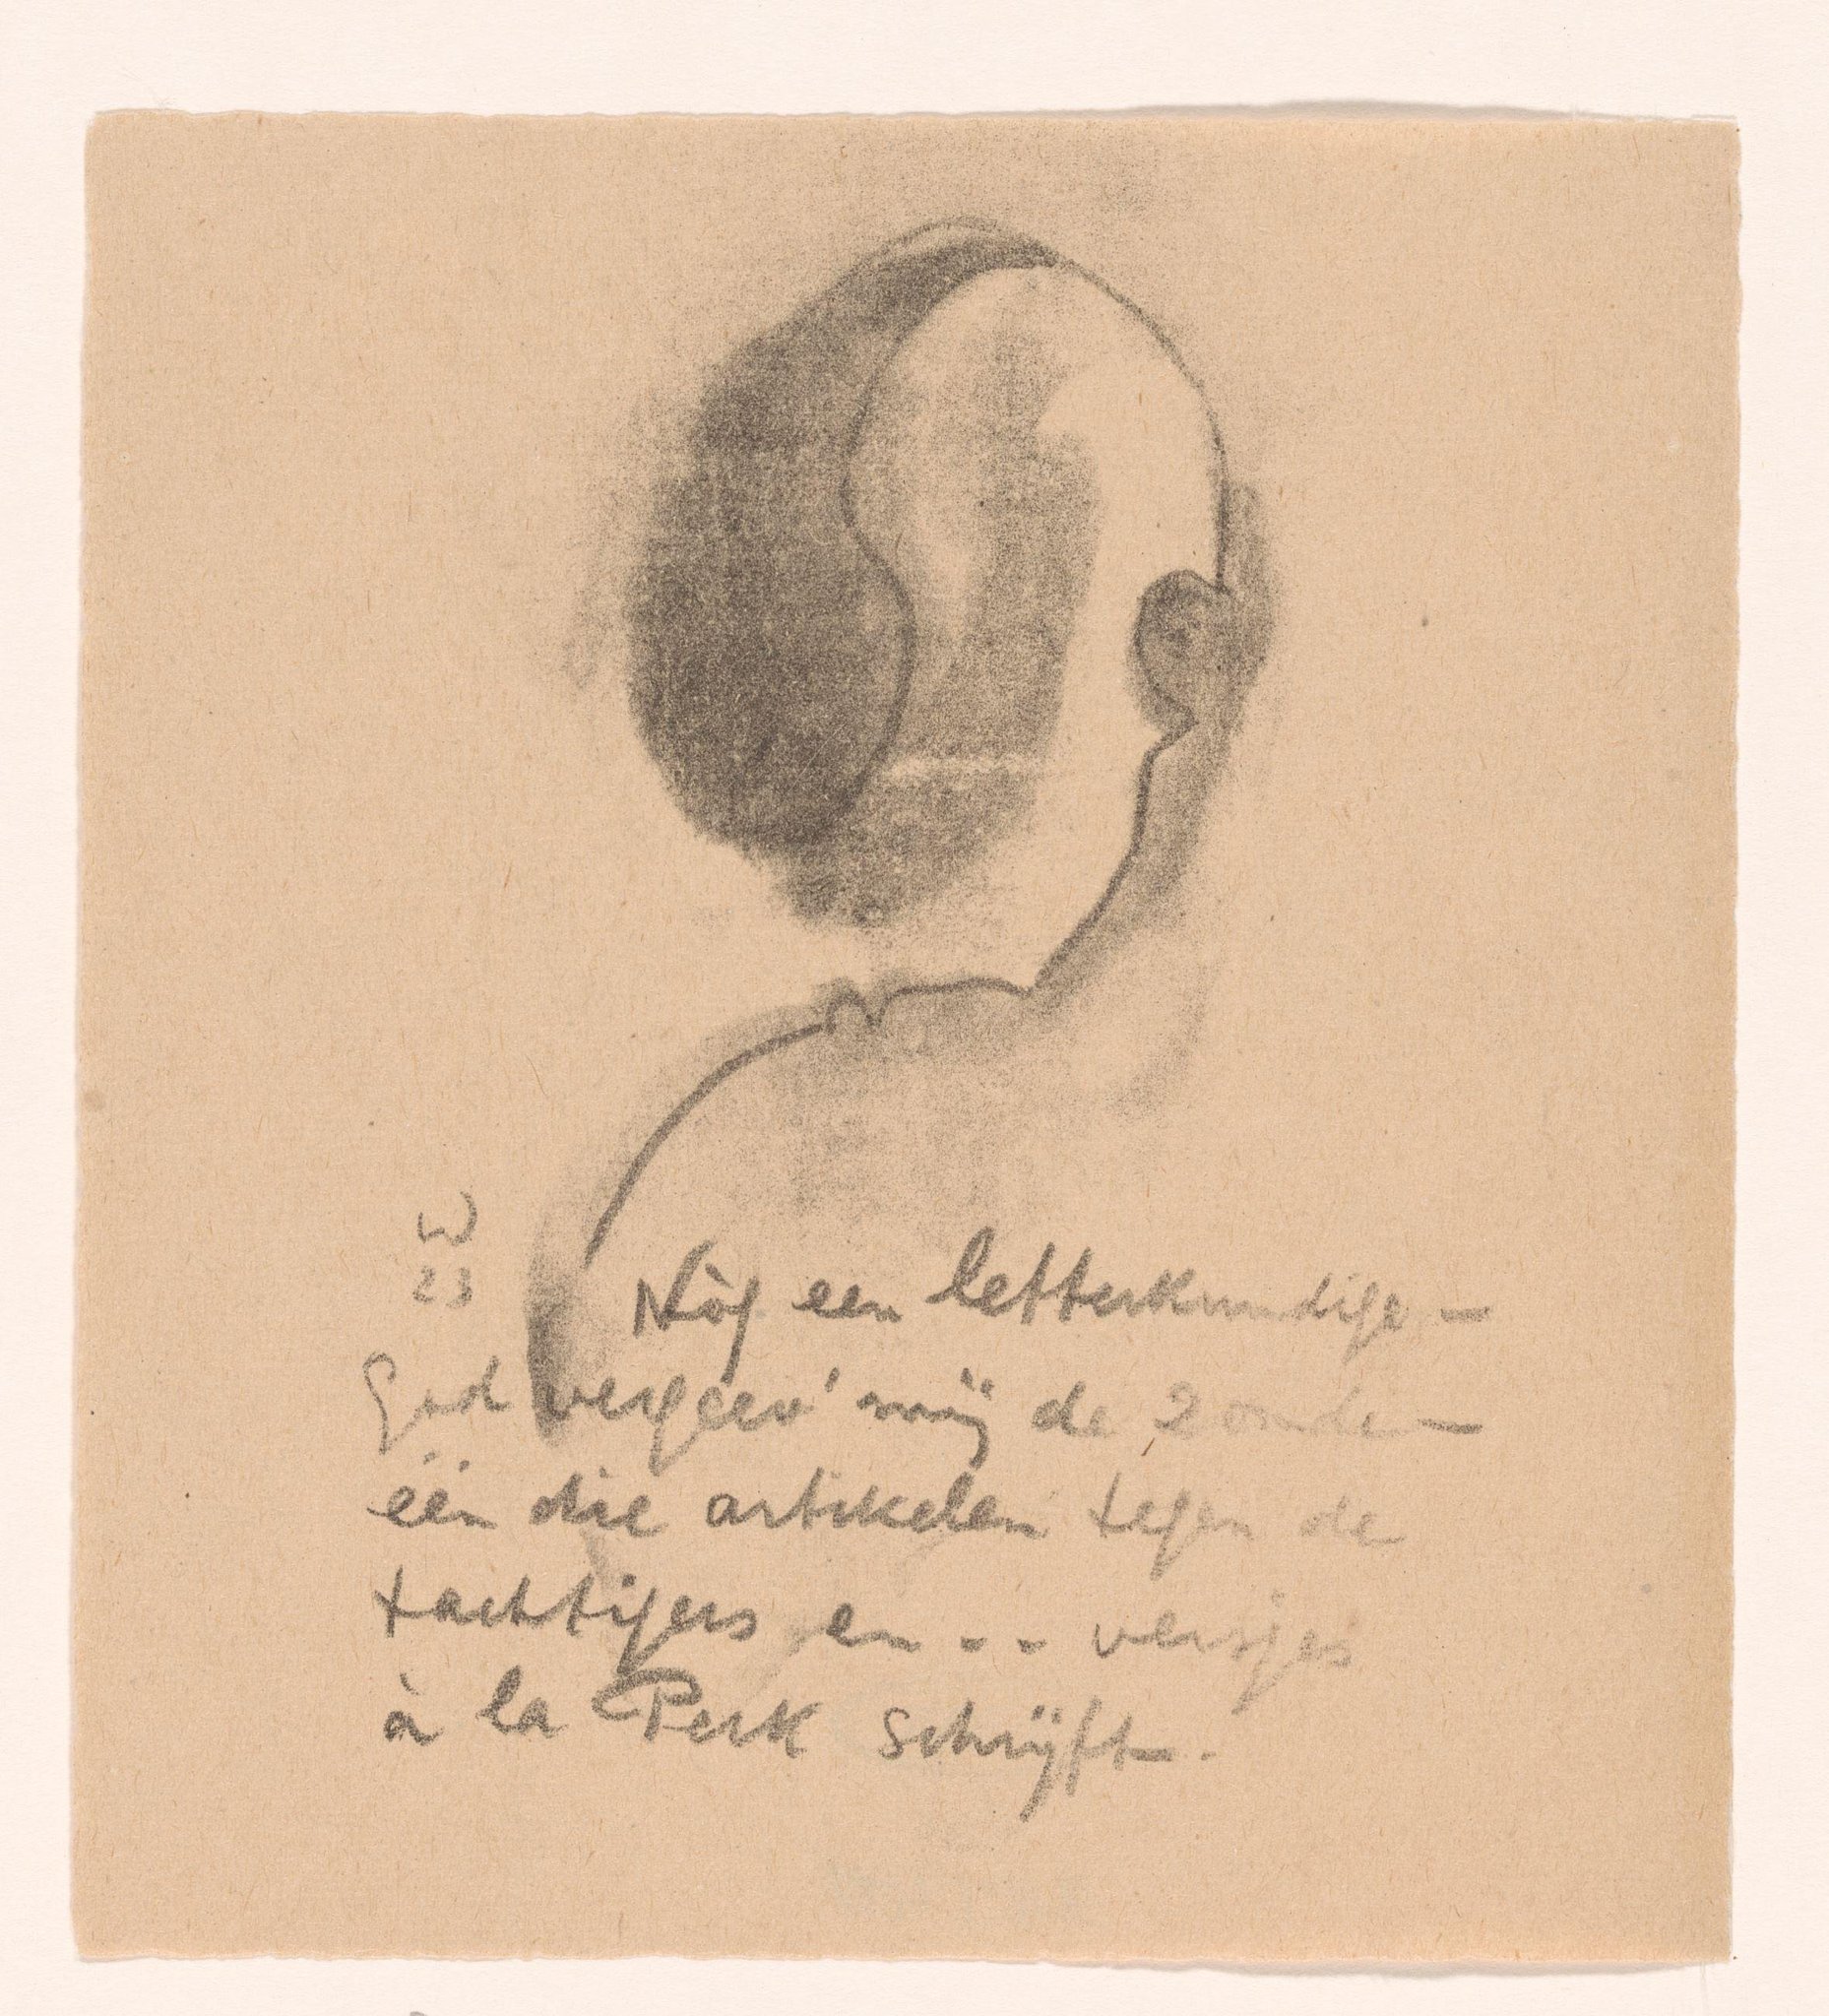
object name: print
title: Karikatuur van een letterkundige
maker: erich wichmann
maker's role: print maker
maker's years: 1890-1929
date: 1923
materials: paper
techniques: lithograph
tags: caricatures (human types), writer, poet, author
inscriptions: collector's mark: Lugt 2228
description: Geabstraheerde figuur. Onderaan de tekst: 'Nòg een letterkundige - God vergeef mij de zonde - één die artikelen tegen de tachtigers en .. versjes à la Perk schrijft.'